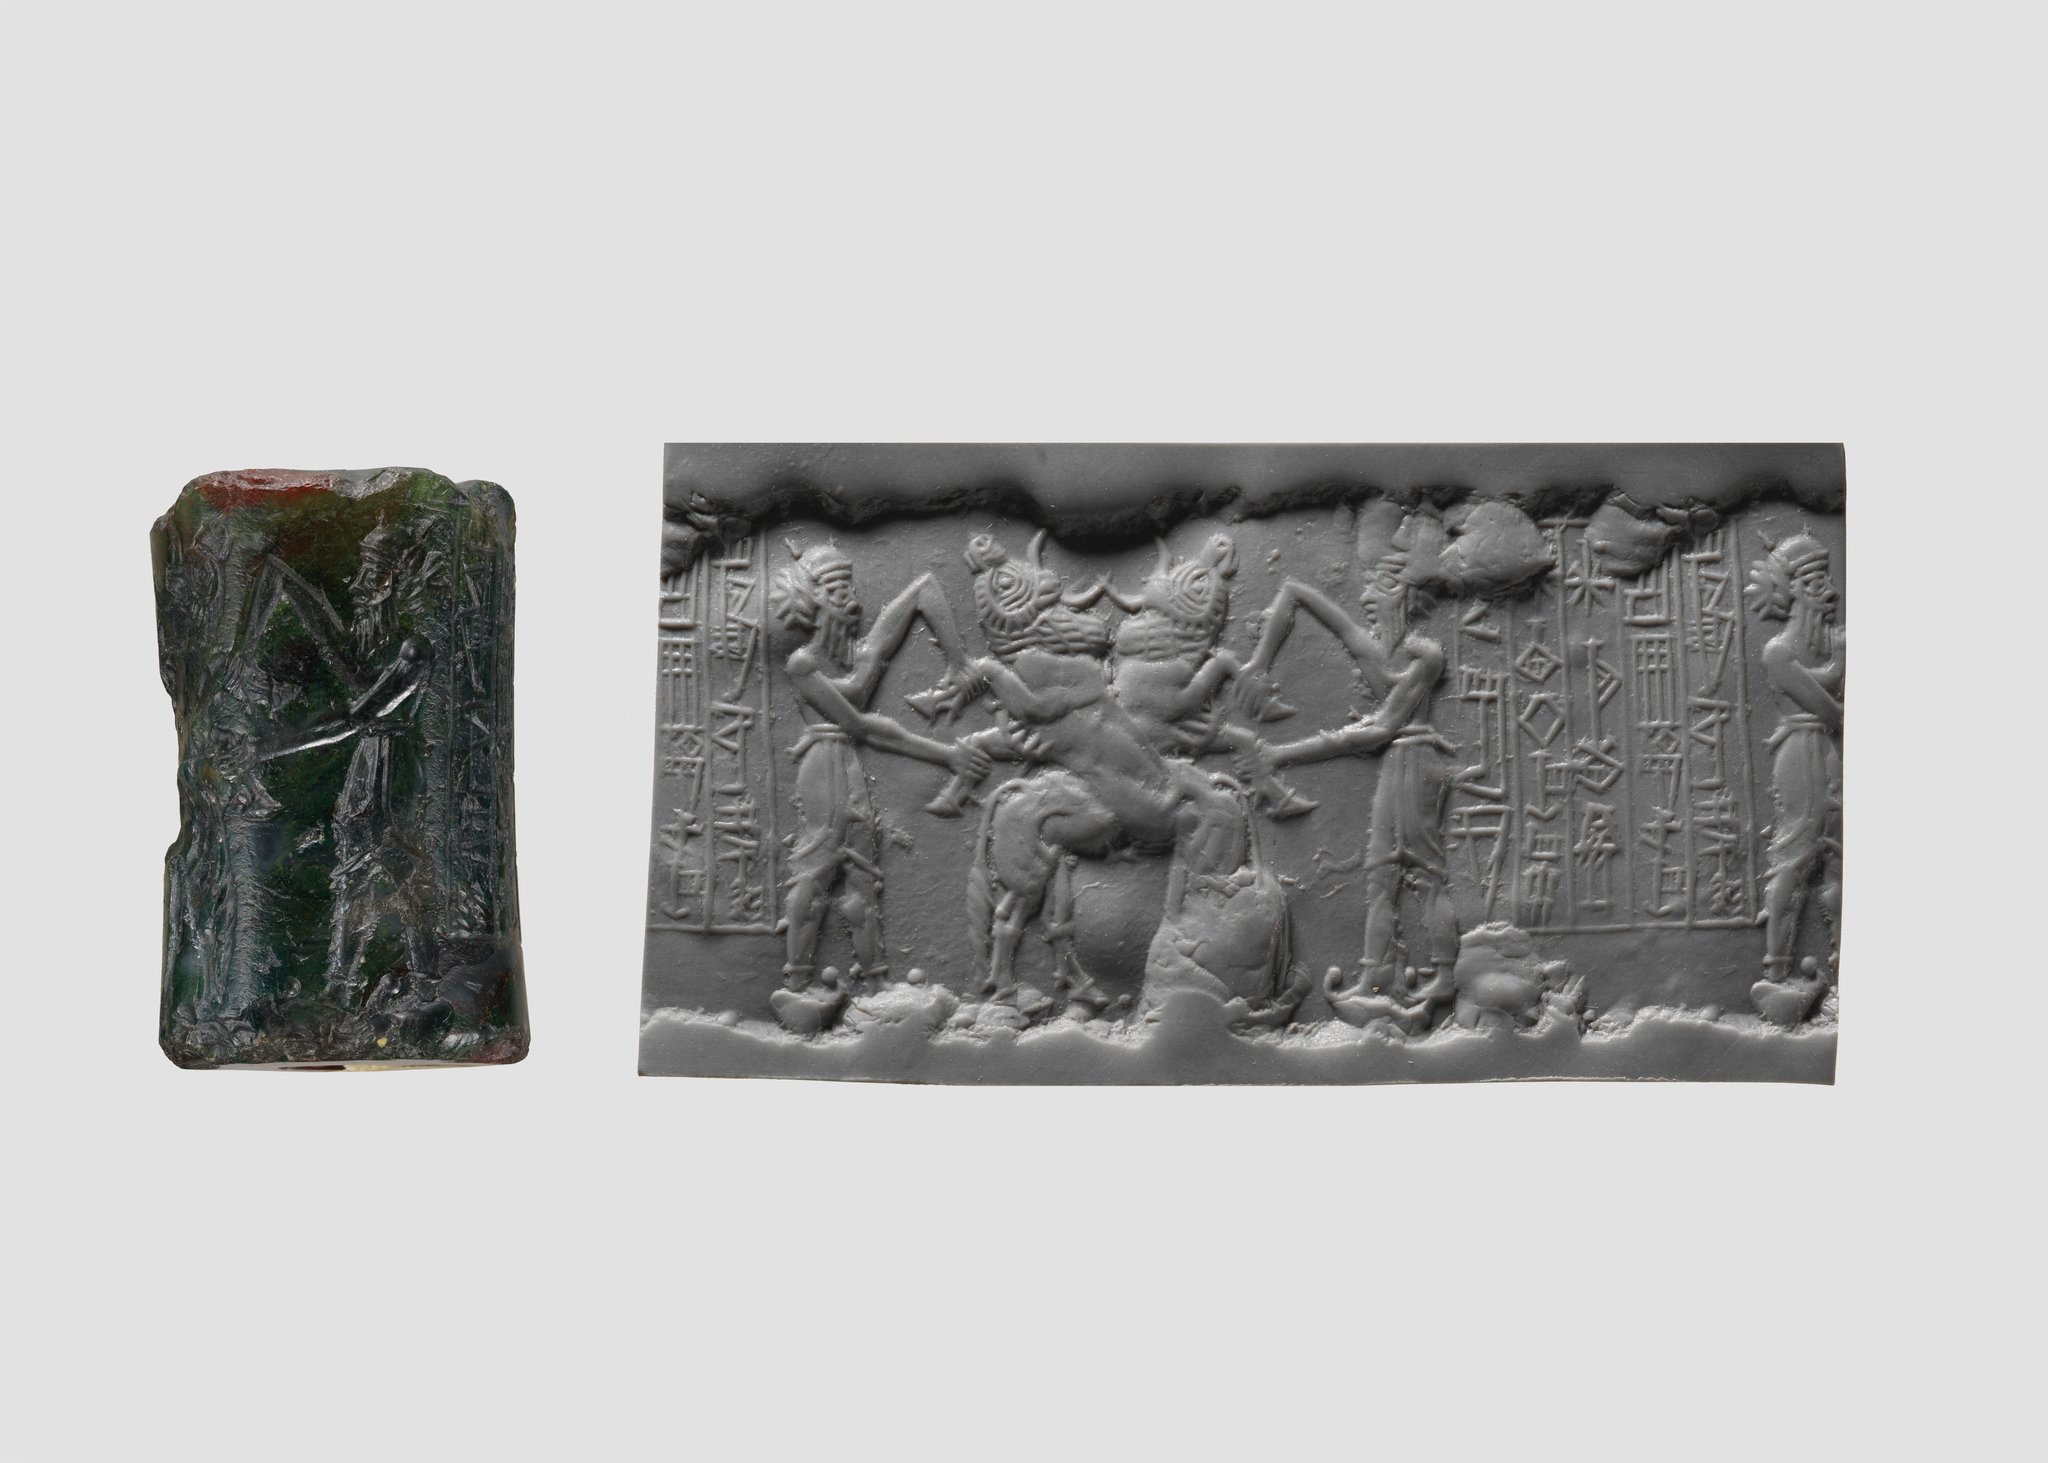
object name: cylinder seal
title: Cylinder seal: contest scene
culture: akkadian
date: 2350-2150 BCE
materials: stone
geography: mesopotamia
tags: animals